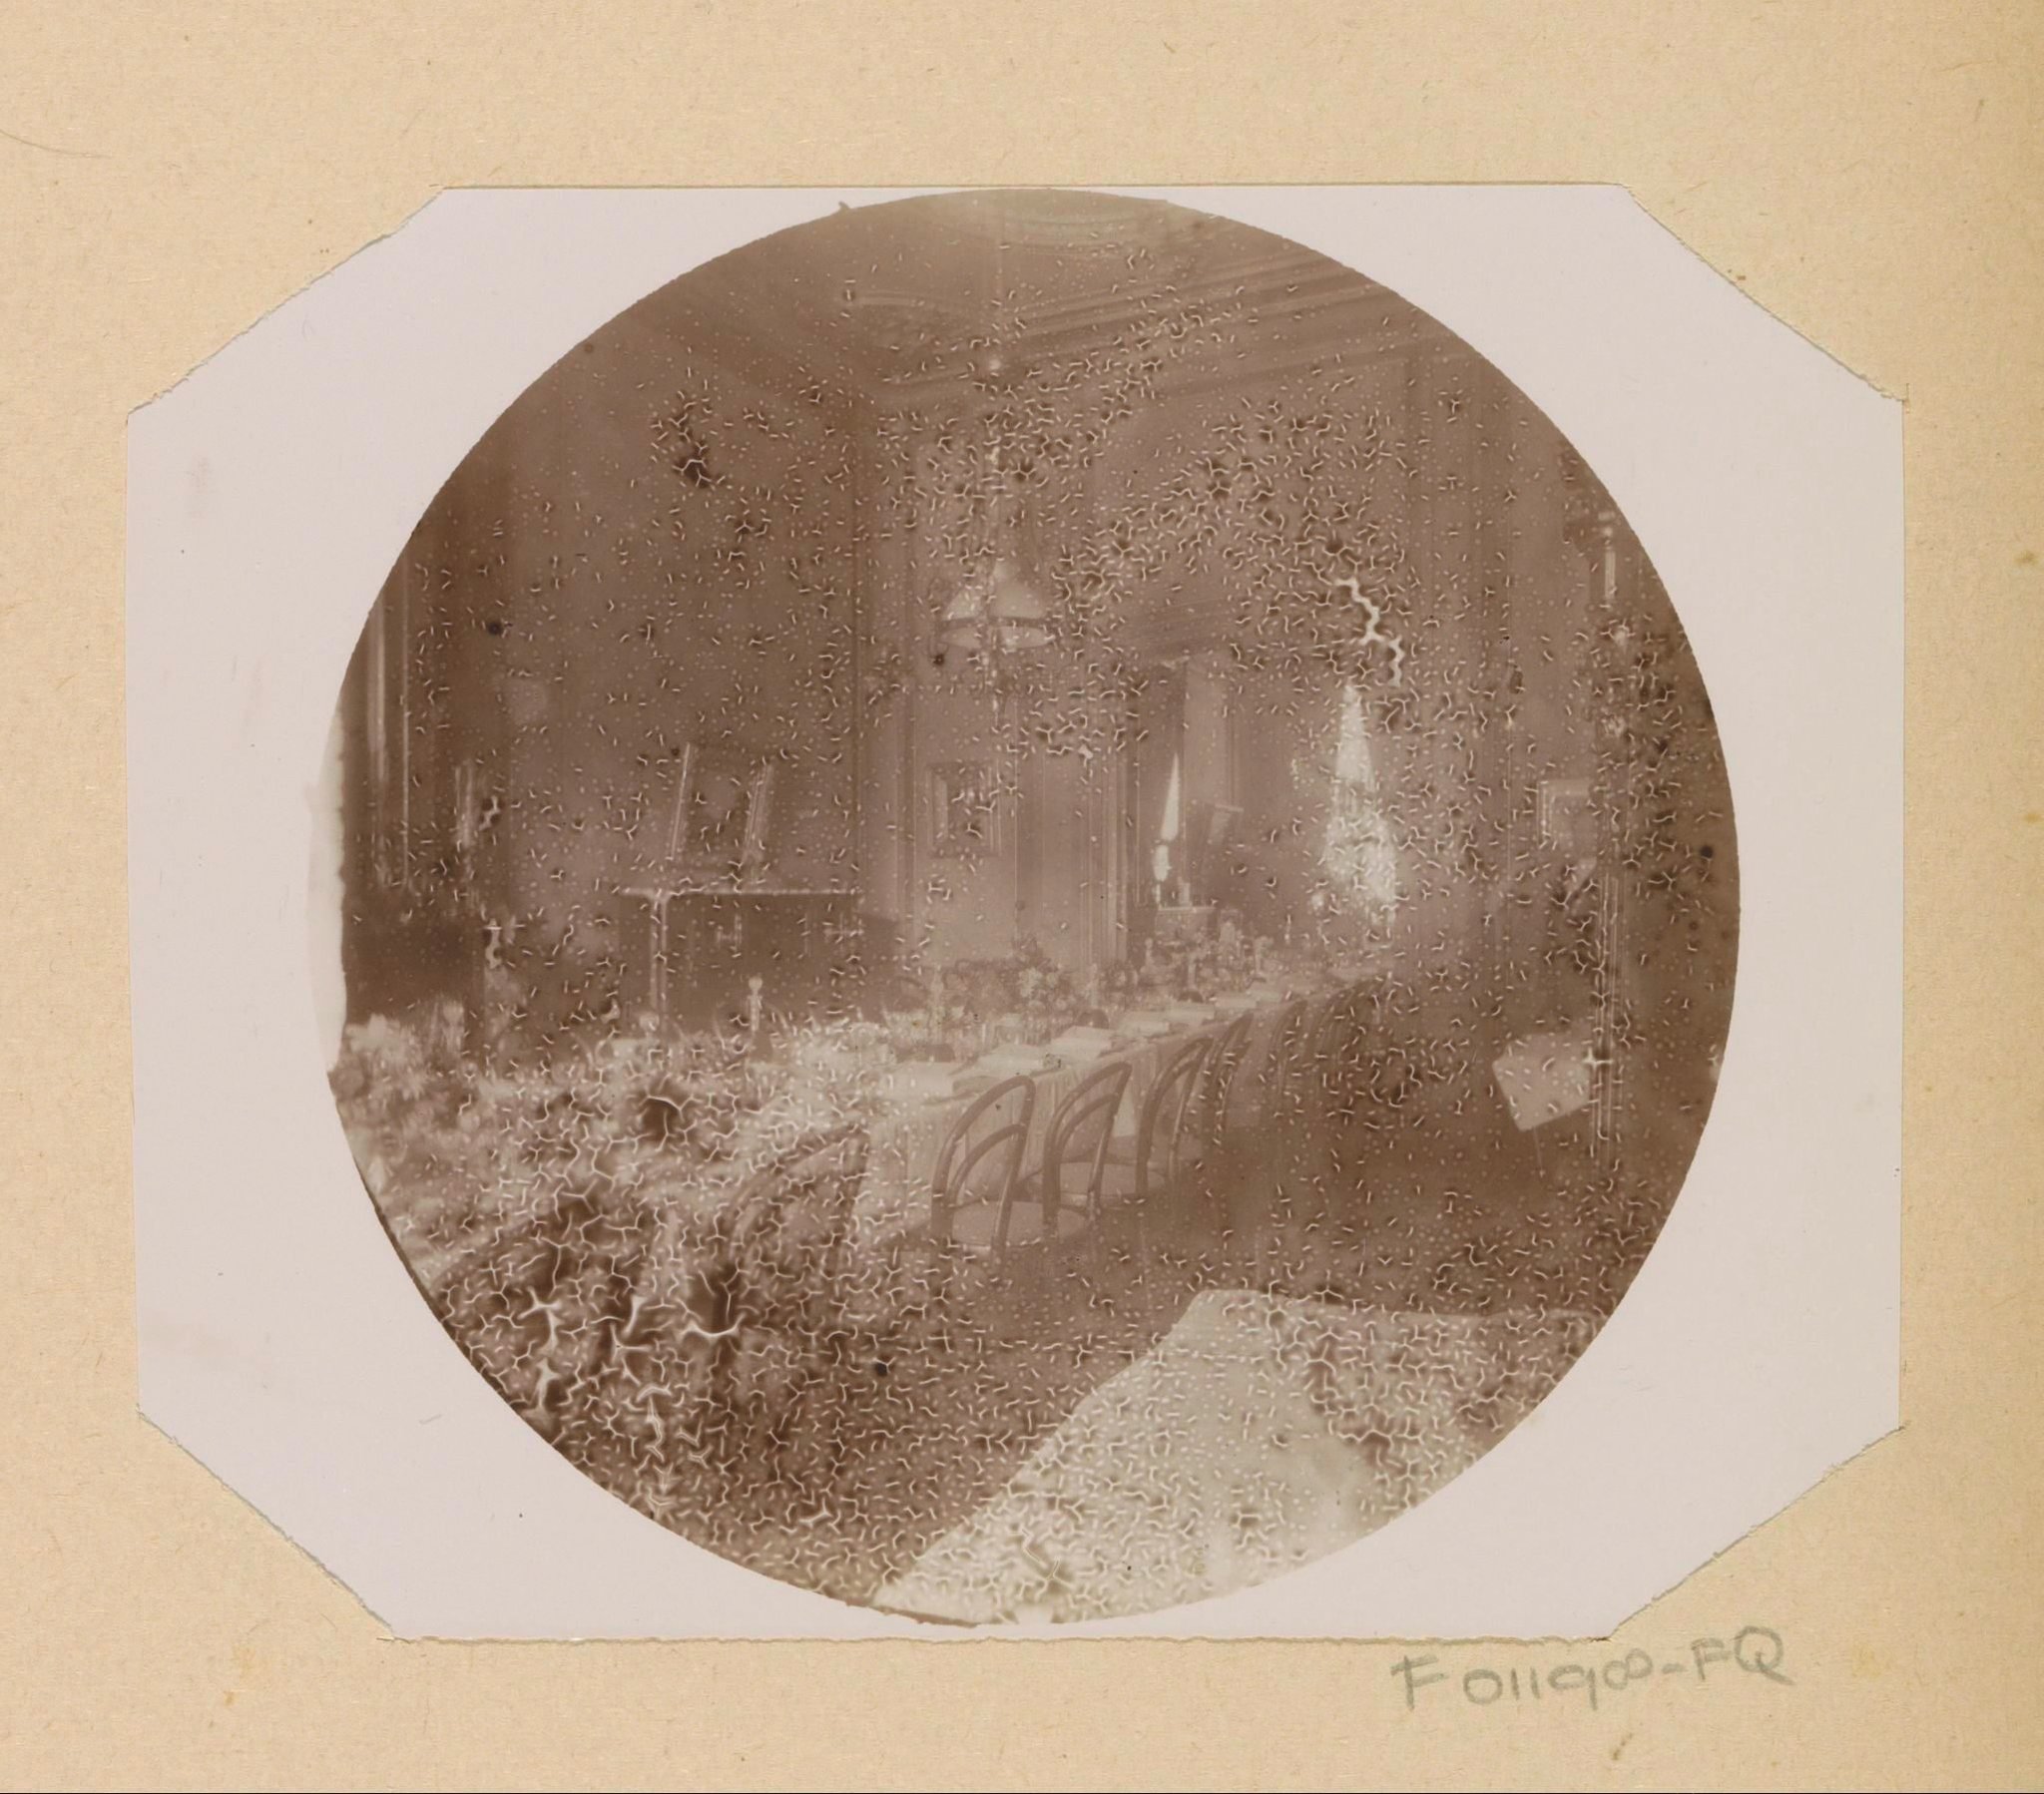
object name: photograph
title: Interieur met gedekte tafel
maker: willem frederik piek jr.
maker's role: fotograaf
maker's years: 1874-1954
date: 1889-1893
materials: paper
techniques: gelatin silver print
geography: amsterdam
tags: dining-room, amsterdam